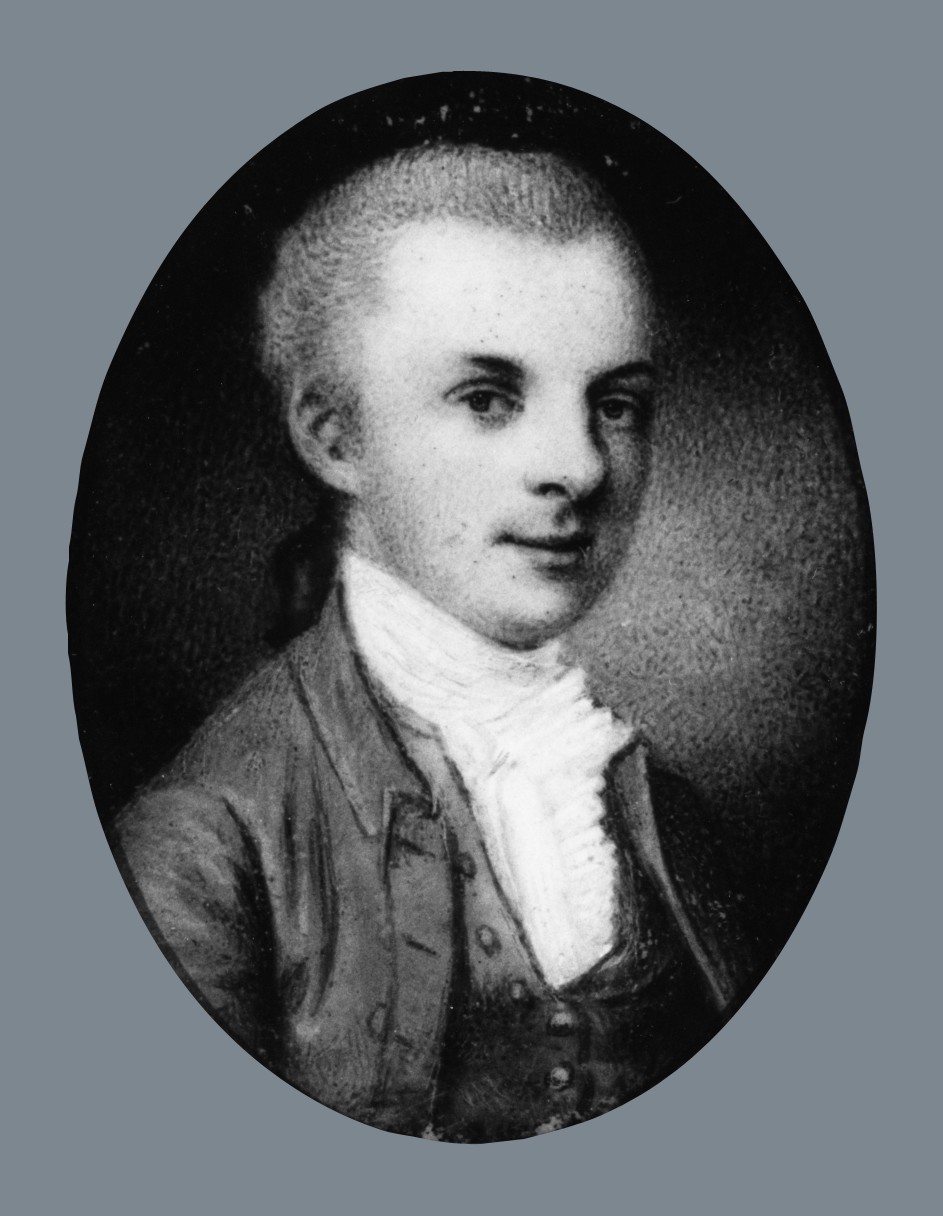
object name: painting, miniature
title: Anthony Butler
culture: american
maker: charles willson peale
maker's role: artist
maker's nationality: american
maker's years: 1741-1827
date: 1782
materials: ivory, watercolor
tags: men,portraits